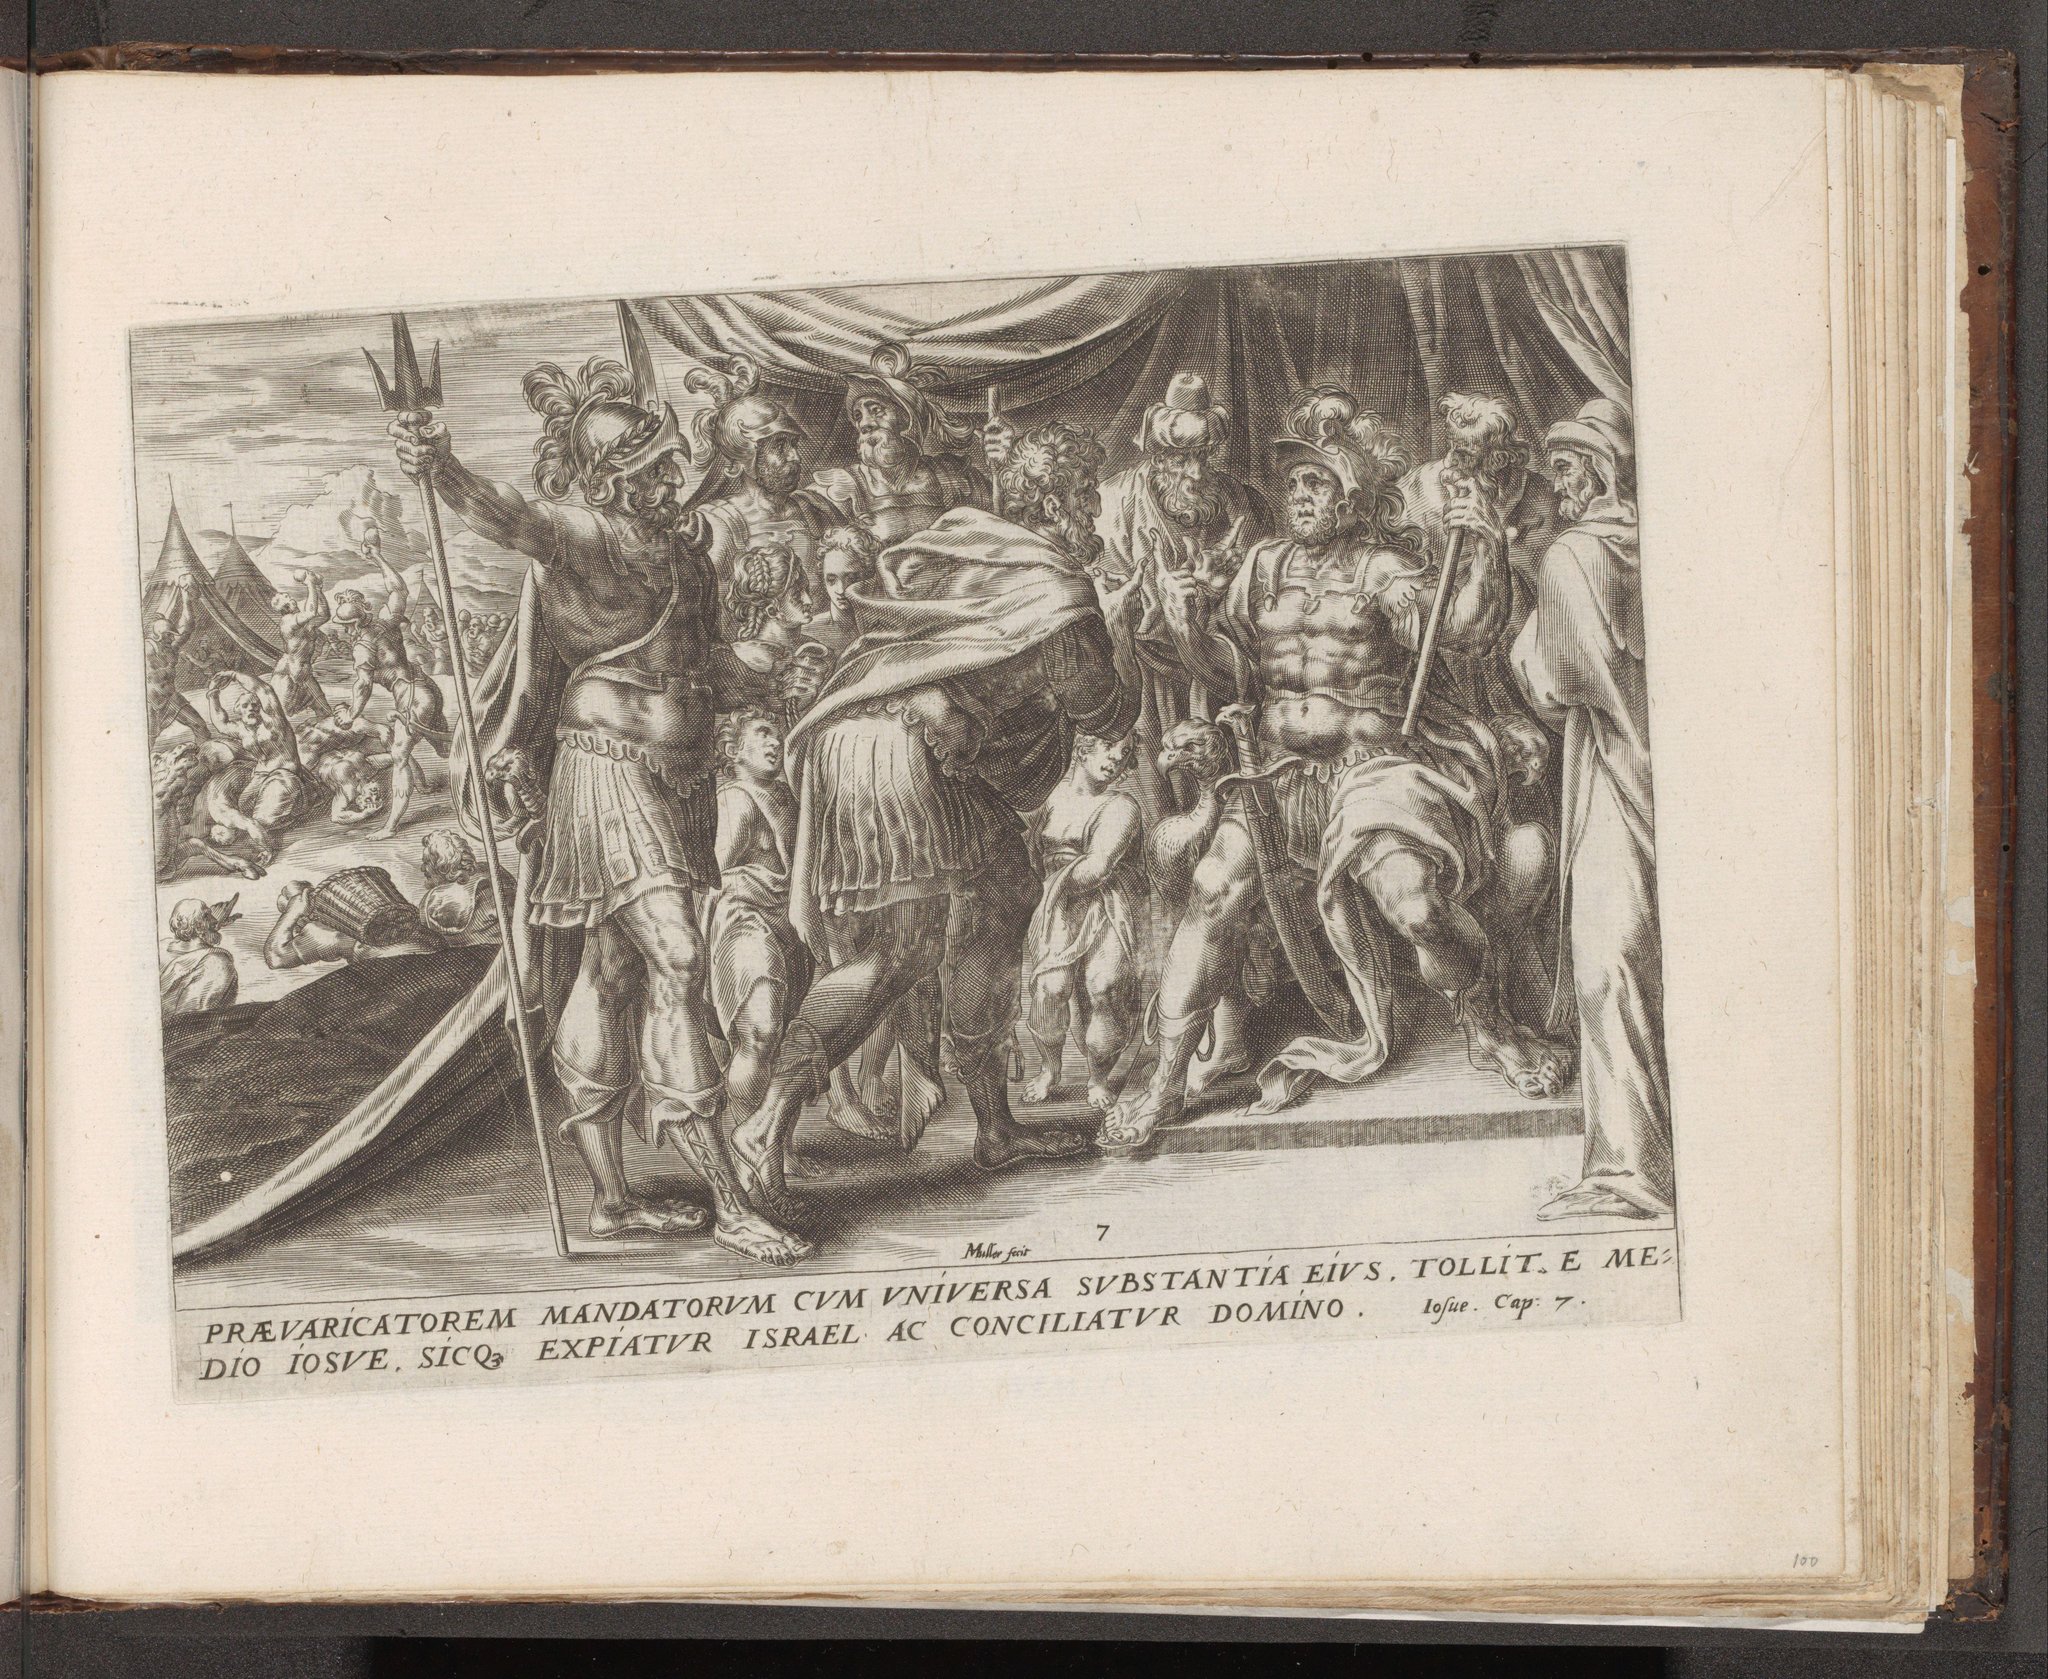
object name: album leaf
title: Achan voor Jozua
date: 1579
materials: paper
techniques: engraving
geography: amsterdam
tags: achan and his family are stoned and burned (aftermath of the fall of jericho), achan confesses to have taken from the spoils a garment and some silver and gold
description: Achan wordt voorgeleid aan Jozua, omdat hij oorlogsbuit had gestolen. Op de achtergrond worden Achan en zijn familie gestenigd. Onder de voorstelling een verwijzing in het Latijn naar de Bijbeltekst in Joz. 7. Prent maakt deel uit van een album.